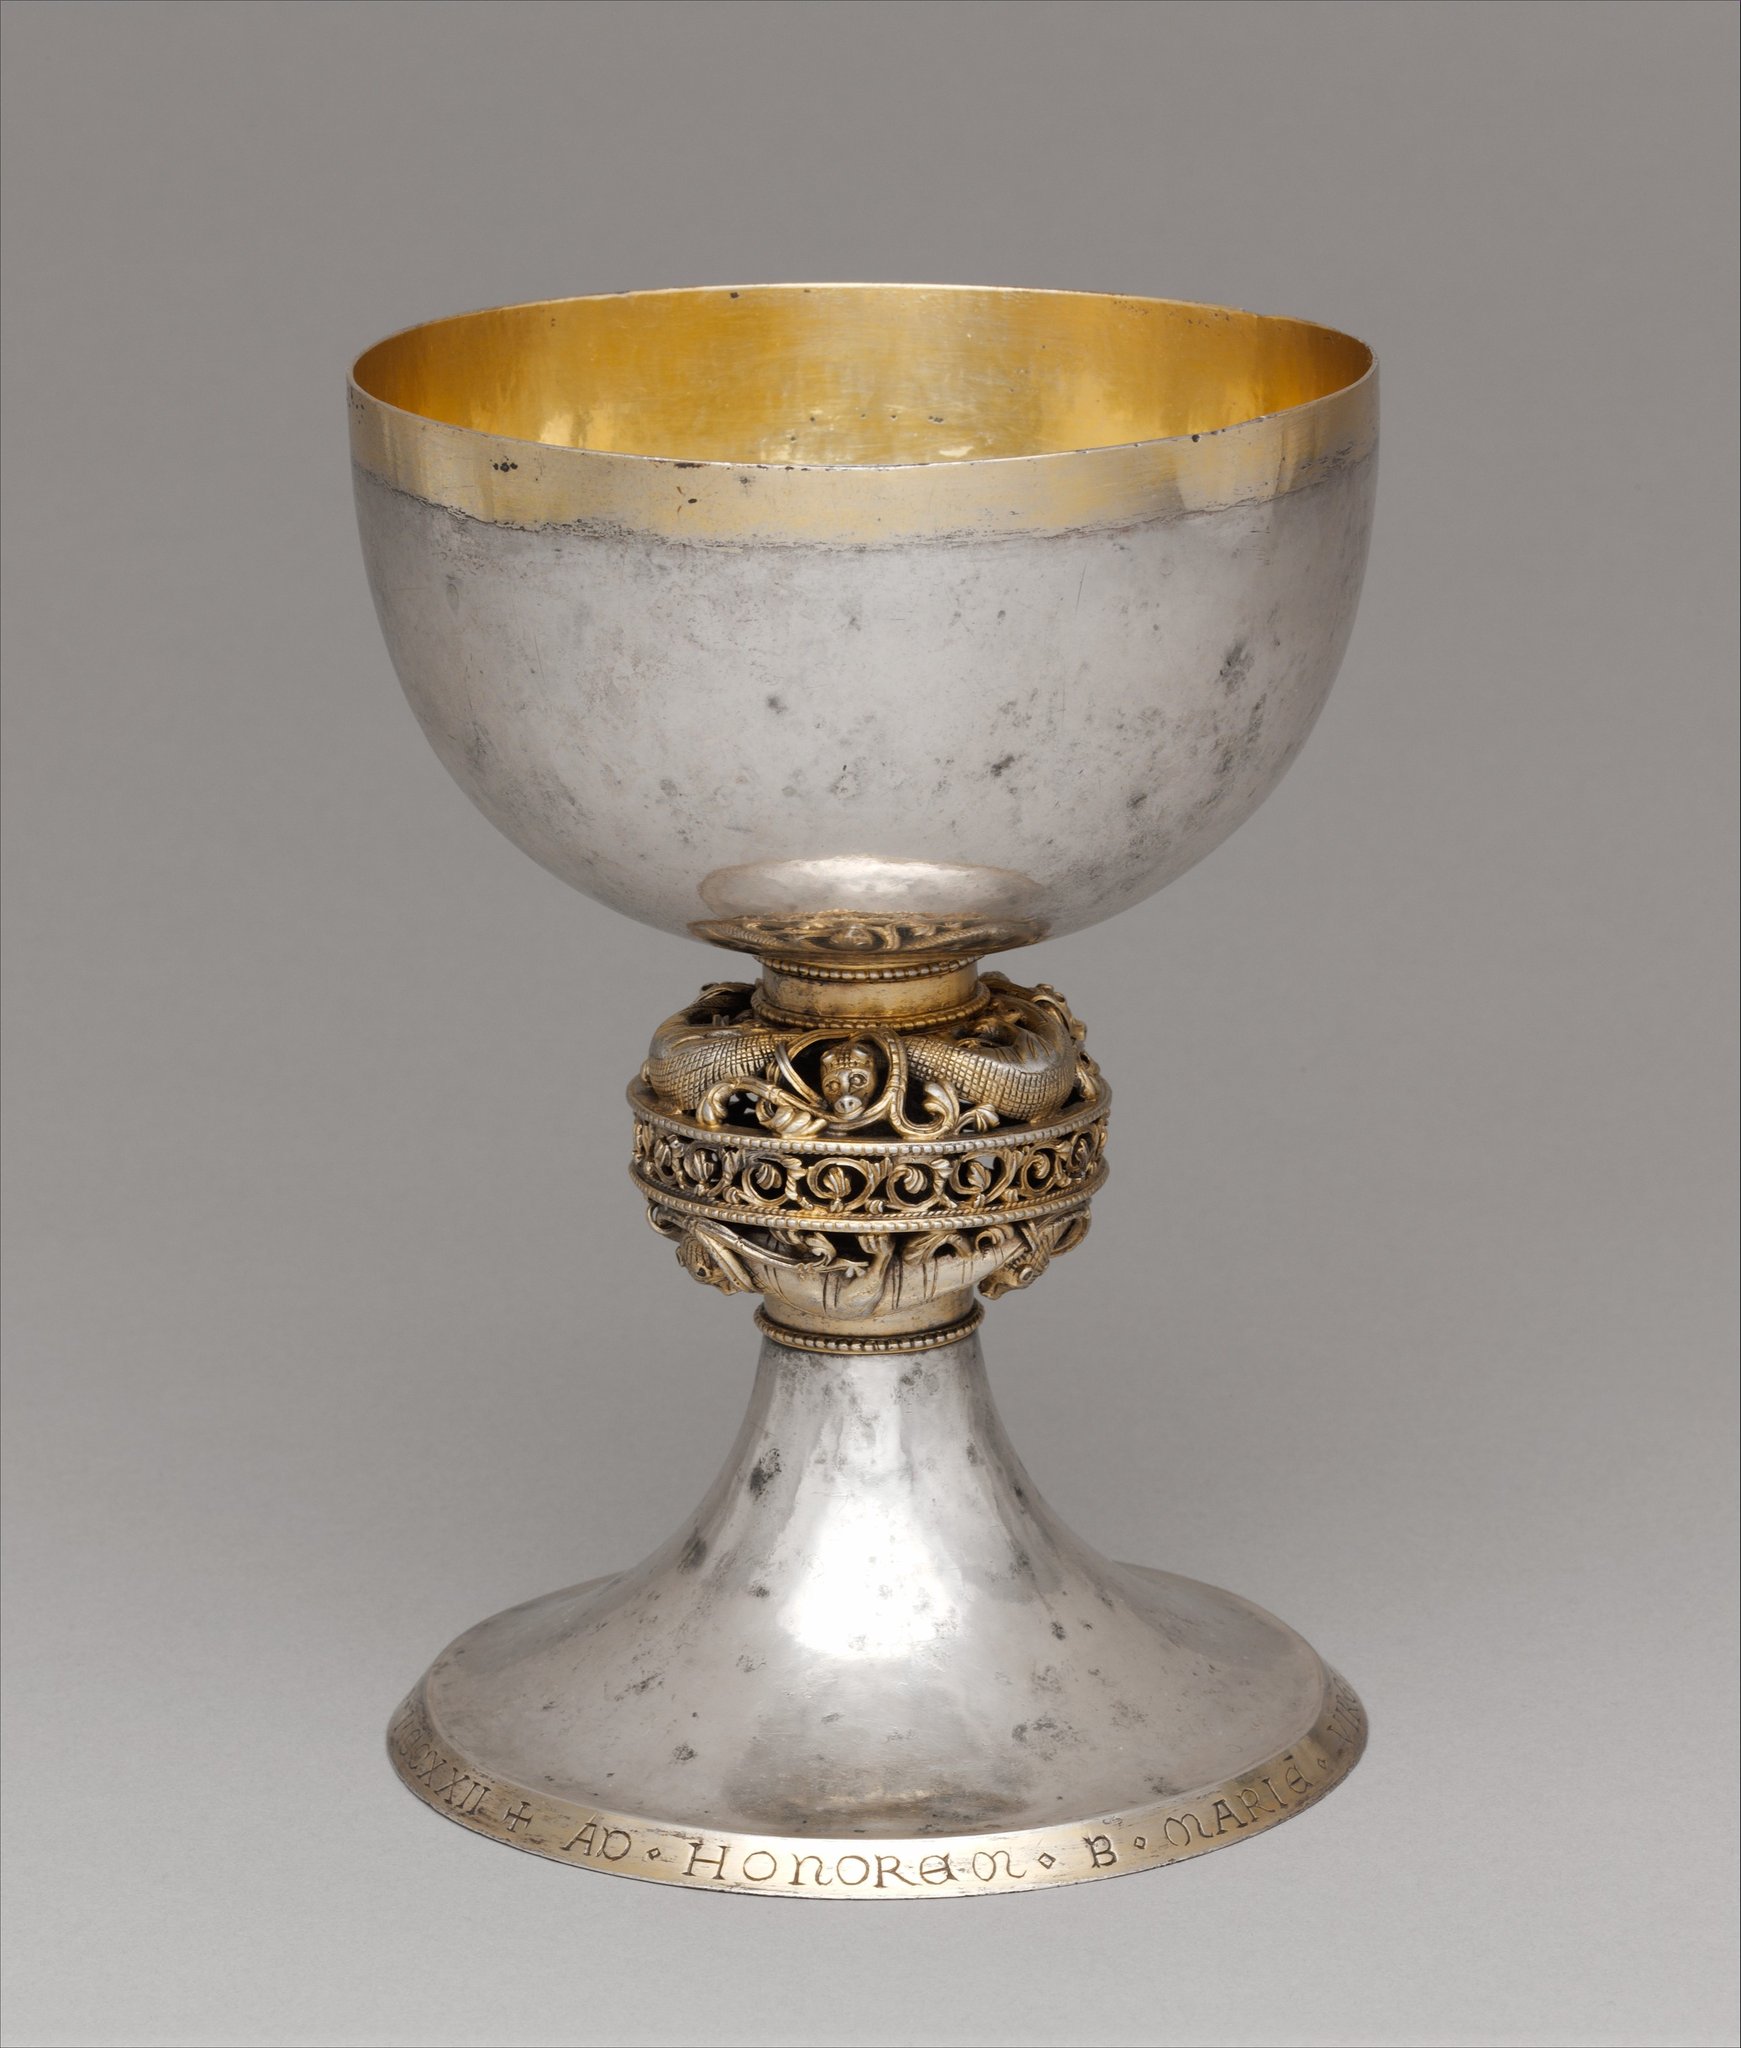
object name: chalice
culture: northern european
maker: brother bertinus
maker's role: artist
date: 1222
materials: silver, silver gilt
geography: northern europe